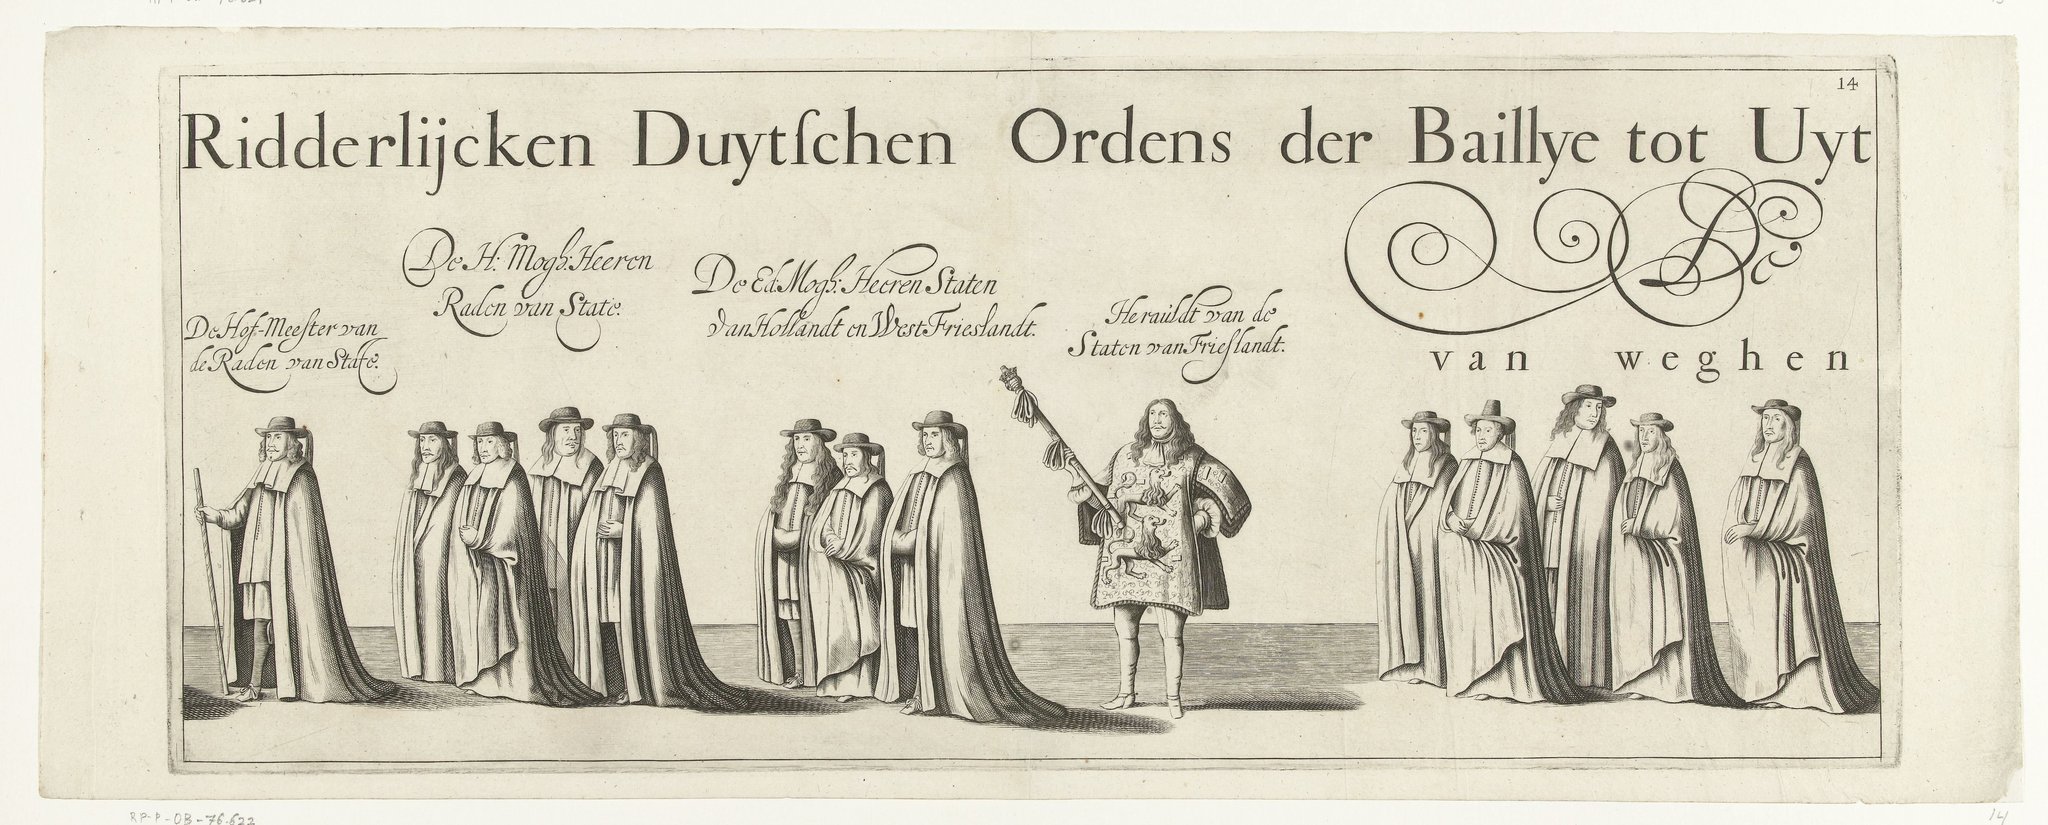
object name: print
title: Rouw-Staetelijcke Lijk-pracht in de Uyt-Vaert en Begraefenisse van het ont-zielde Lichaem van (...) Wilhelm Frederich (...) Overleden binnen Leeuwarden (...) den een-en-twintichsten October, MDCLXIV. en aldaer in 't Choor van de Jacobijner Kerck, den vyfthienden december MDCLXIV. Oude Stijl (...)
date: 1666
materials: paper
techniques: engraving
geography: leeuwarden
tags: cortege, funeral procession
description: Begrafenisoptocht van Willem Frederik, graaf van Nassau-Dietz, in Leeuwarden op 6 januari 1665. Deel van de begrafenisstoet. Plaat nr. 14 in een ensemble van 25 ongemonteerde genummerde platen en twee tekstbladen die samen een lange fries vormen.